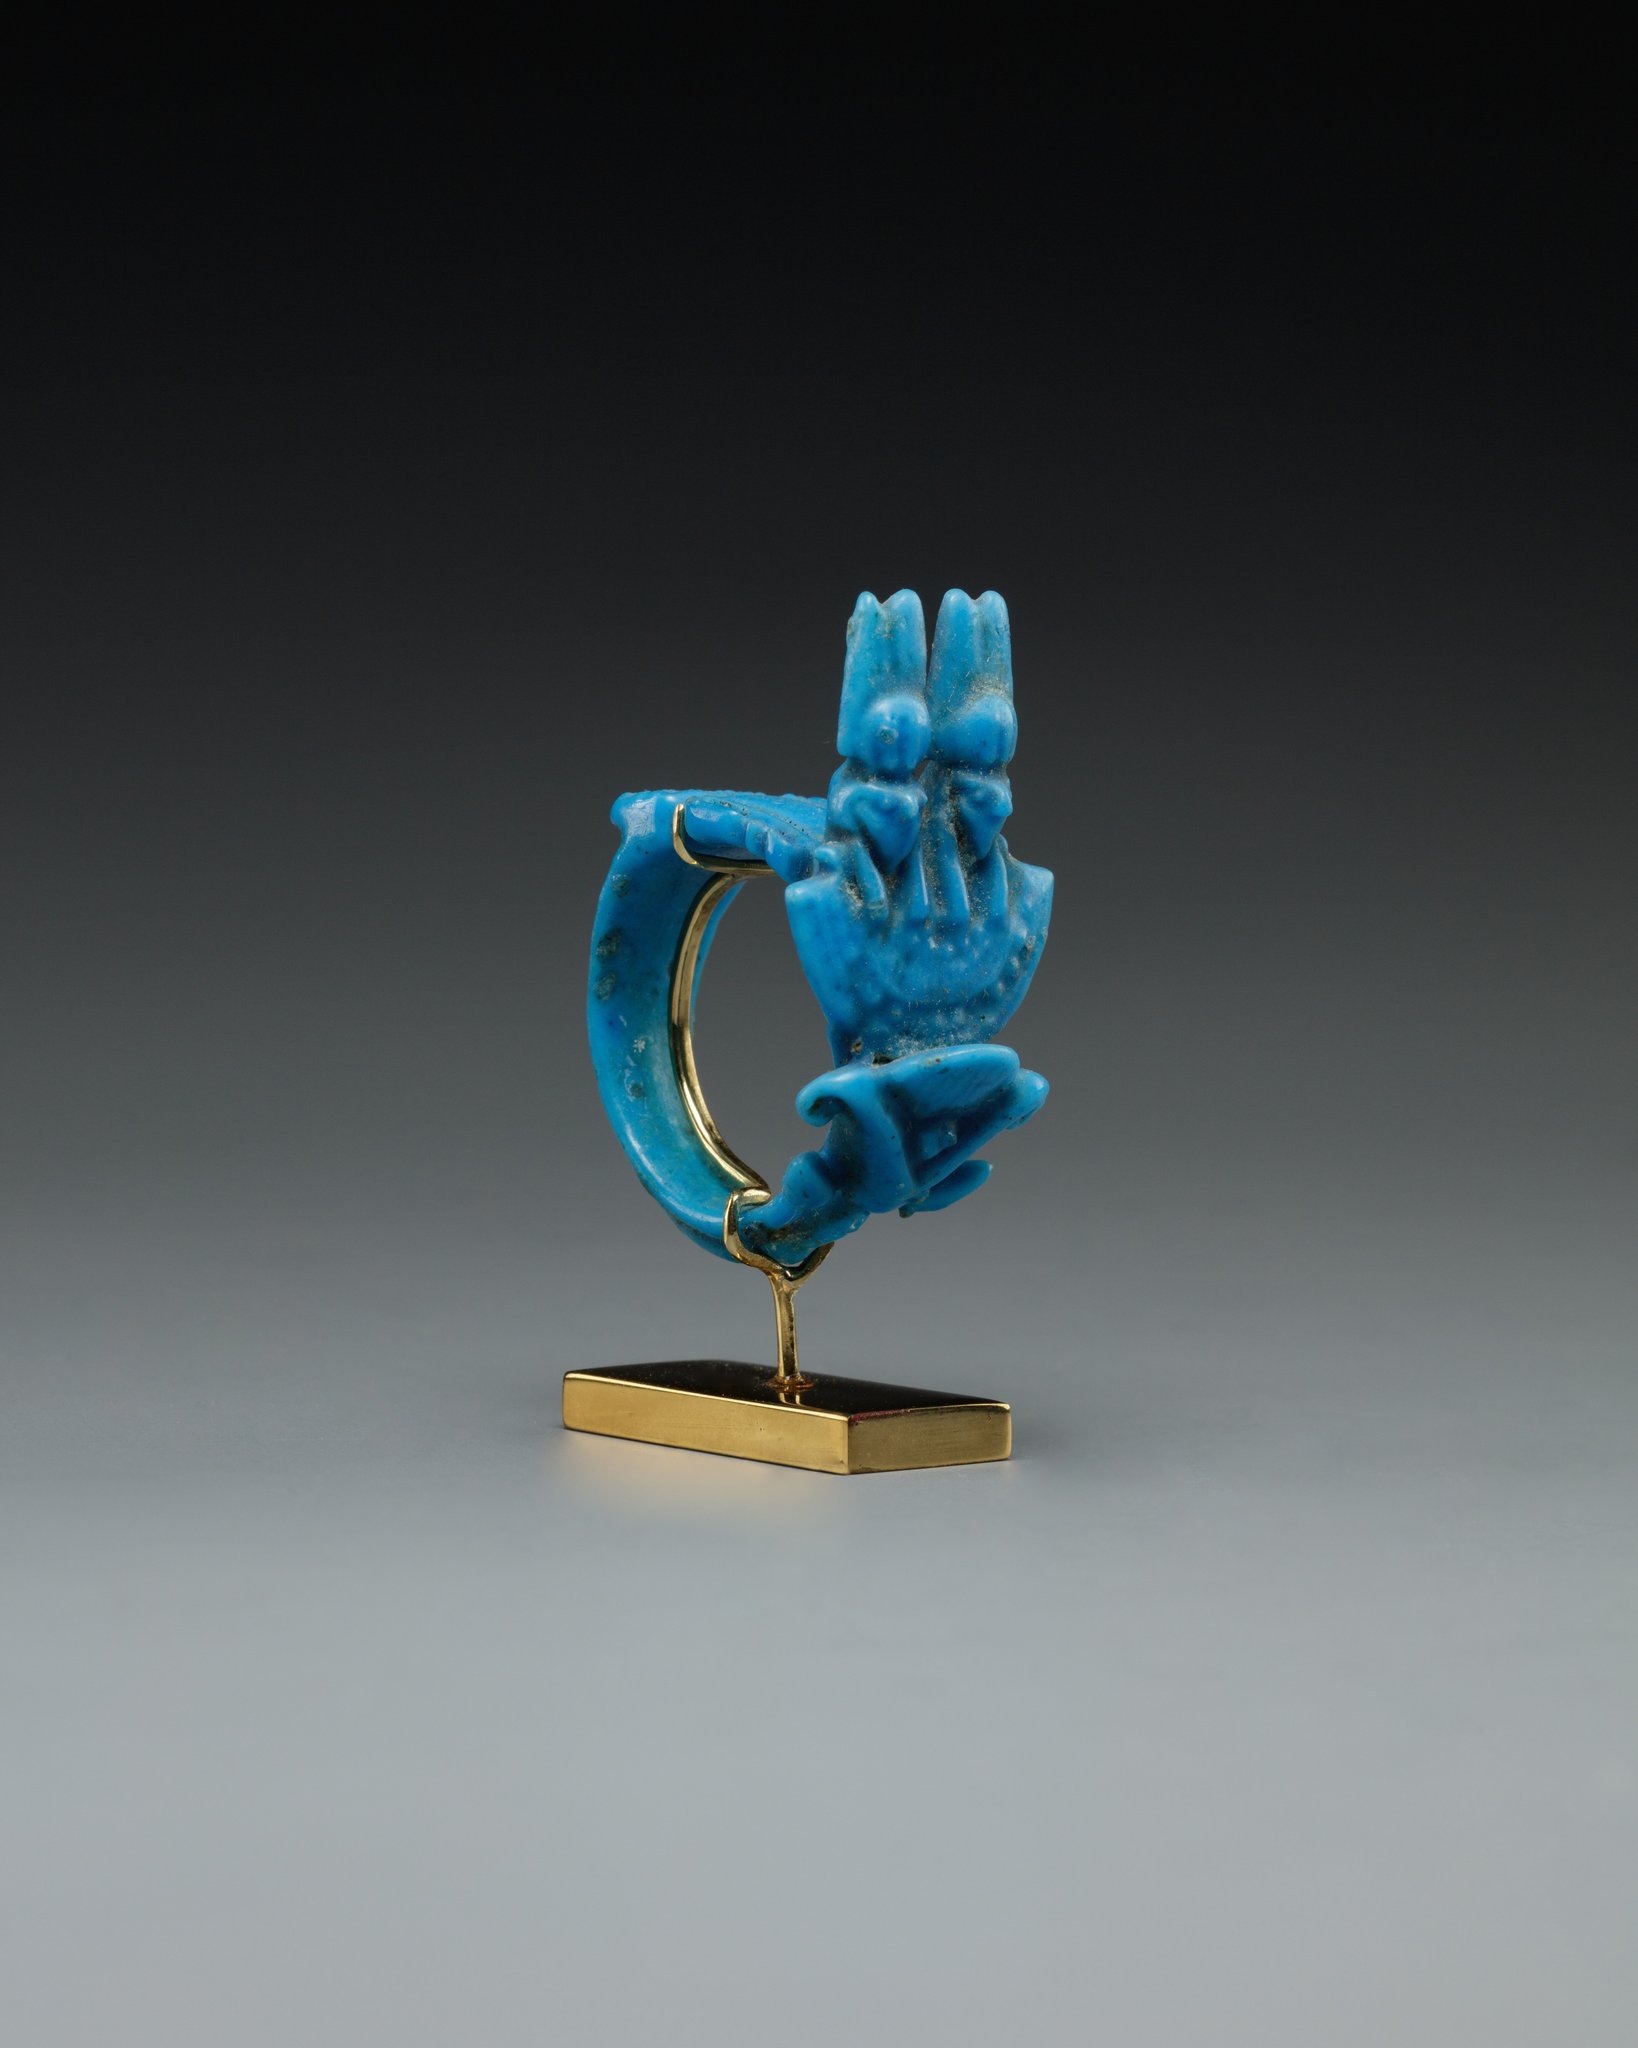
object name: ring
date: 1295-1185 BCE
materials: faience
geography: egypt